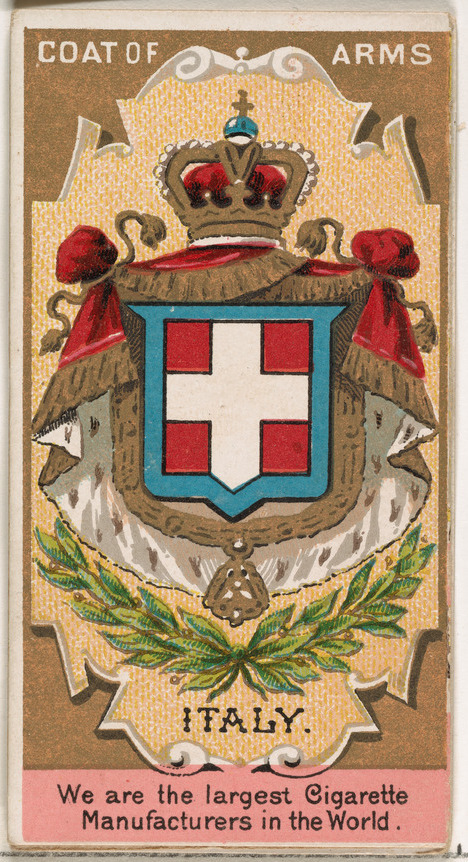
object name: print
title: Humbert I, King of Italy, from the Rulers, Flags, and Coats of Arms series (N126-2) issued by W. Duke, Sons & Co.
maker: w. duke, sons & co.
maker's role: publisher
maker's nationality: american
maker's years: 1870-1920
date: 1888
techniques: color lithograph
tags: kings,portraits,coat of arms,flags